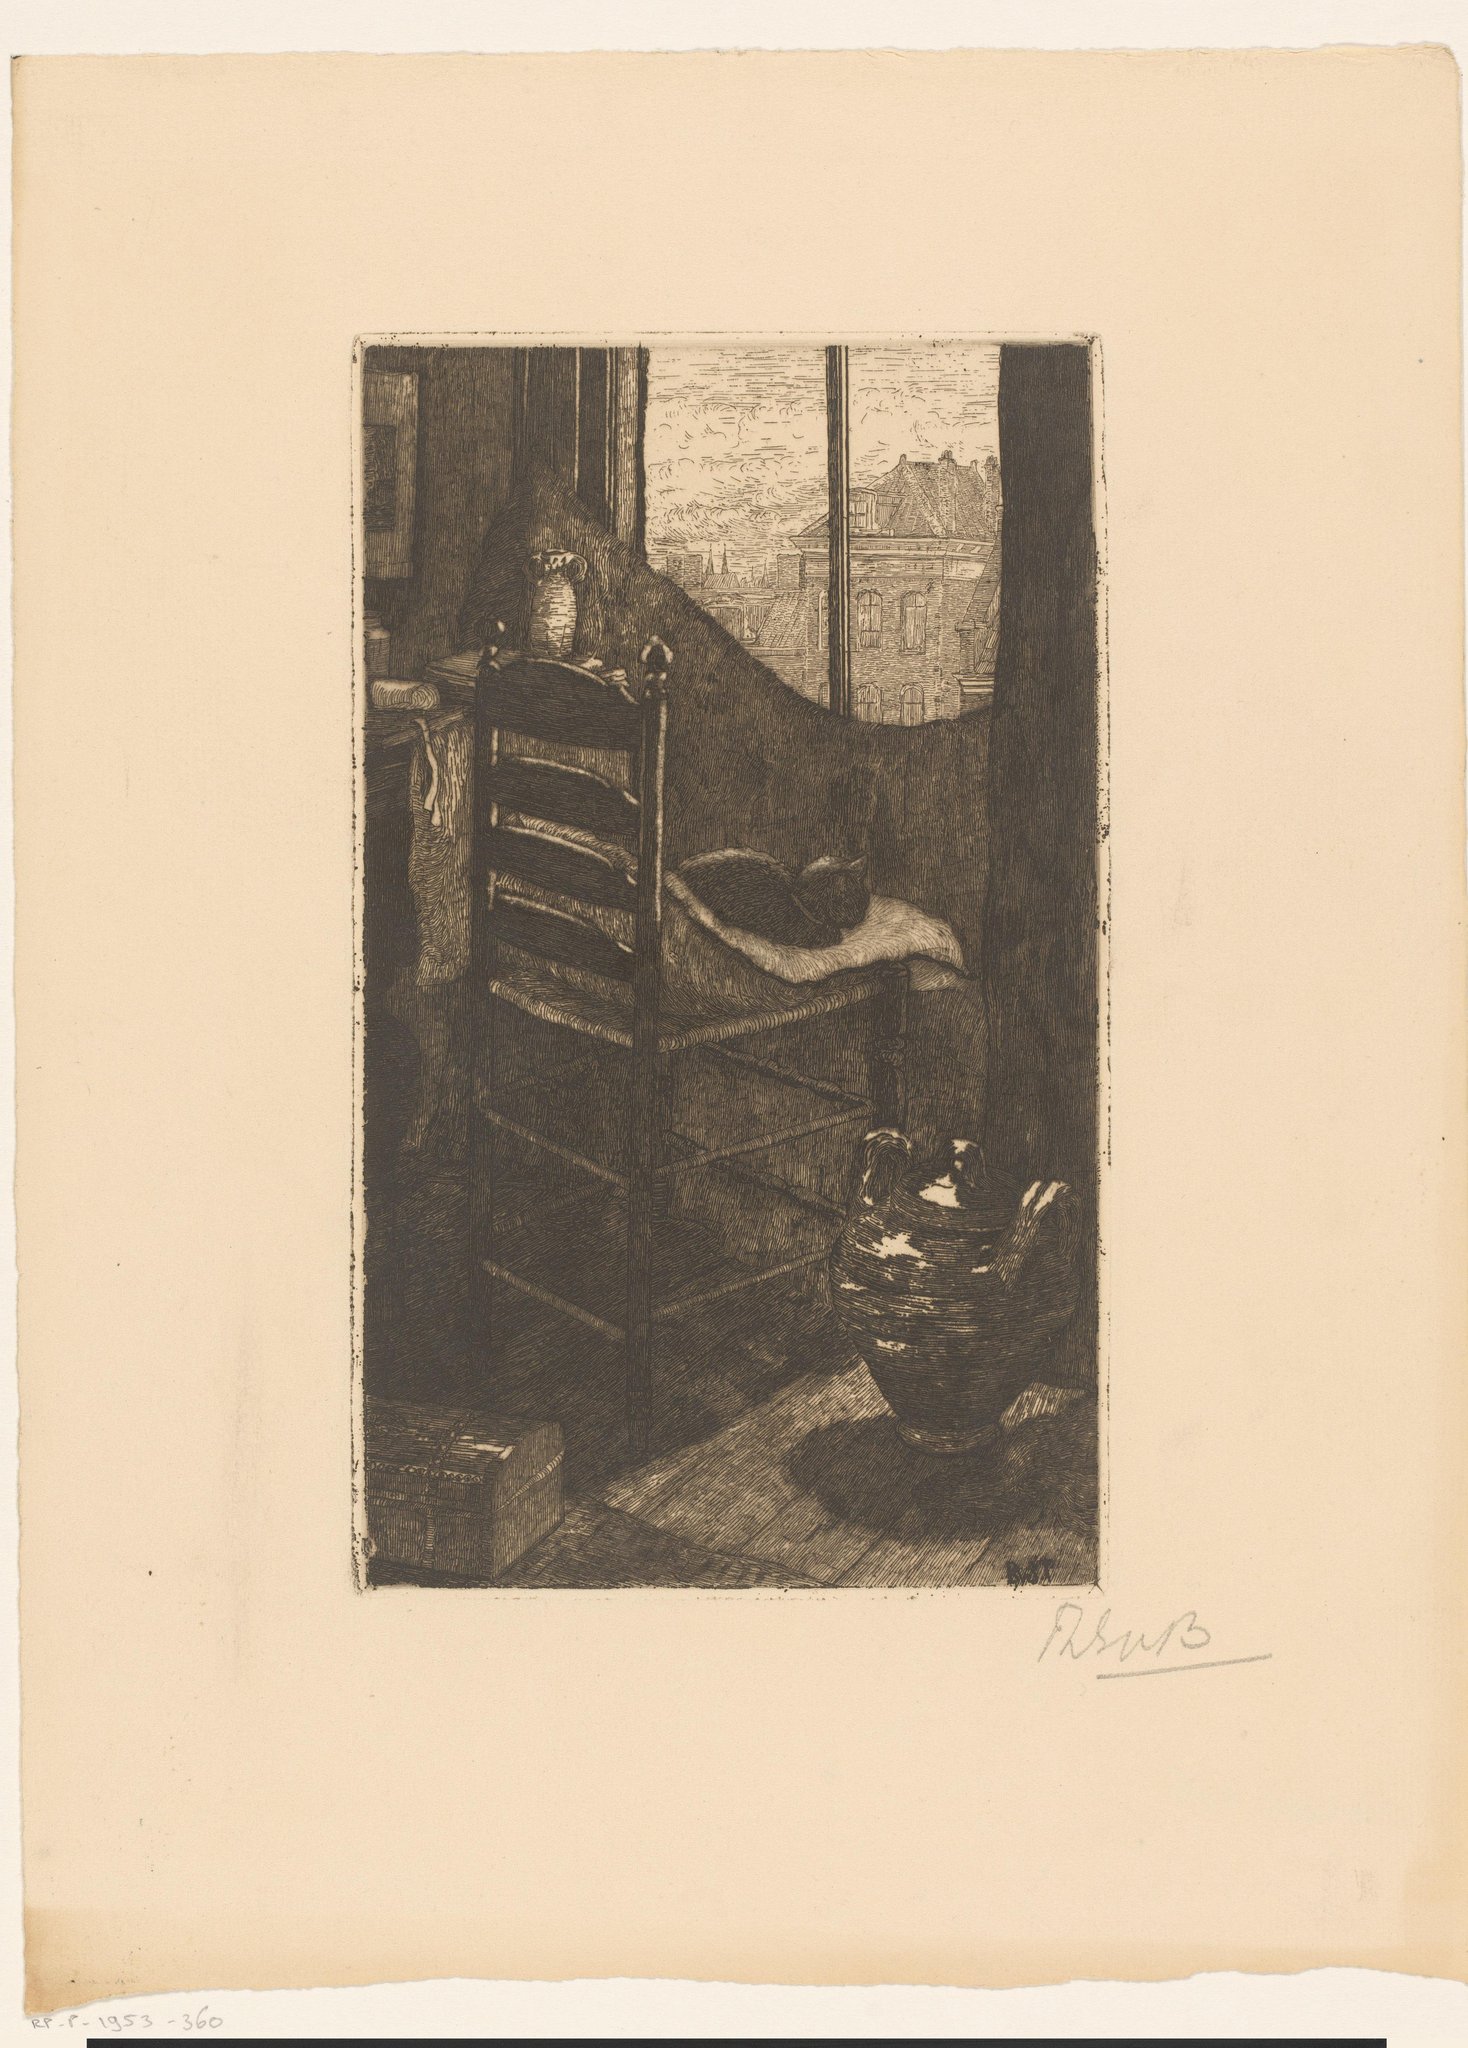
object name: print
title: Poes op de stoel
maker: theodora jacoba van bosse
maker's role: print maker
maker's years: 1874-1953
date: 1899-1953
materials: paper, ink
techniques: aquatint, drypoint, etching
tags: cat, interior of the house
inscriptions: collector's mark: Lugt 2228, monogram: ‘TJvB’, monogram: ‘BvJT’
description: Interieur met bij het venster een kat op een stoel.